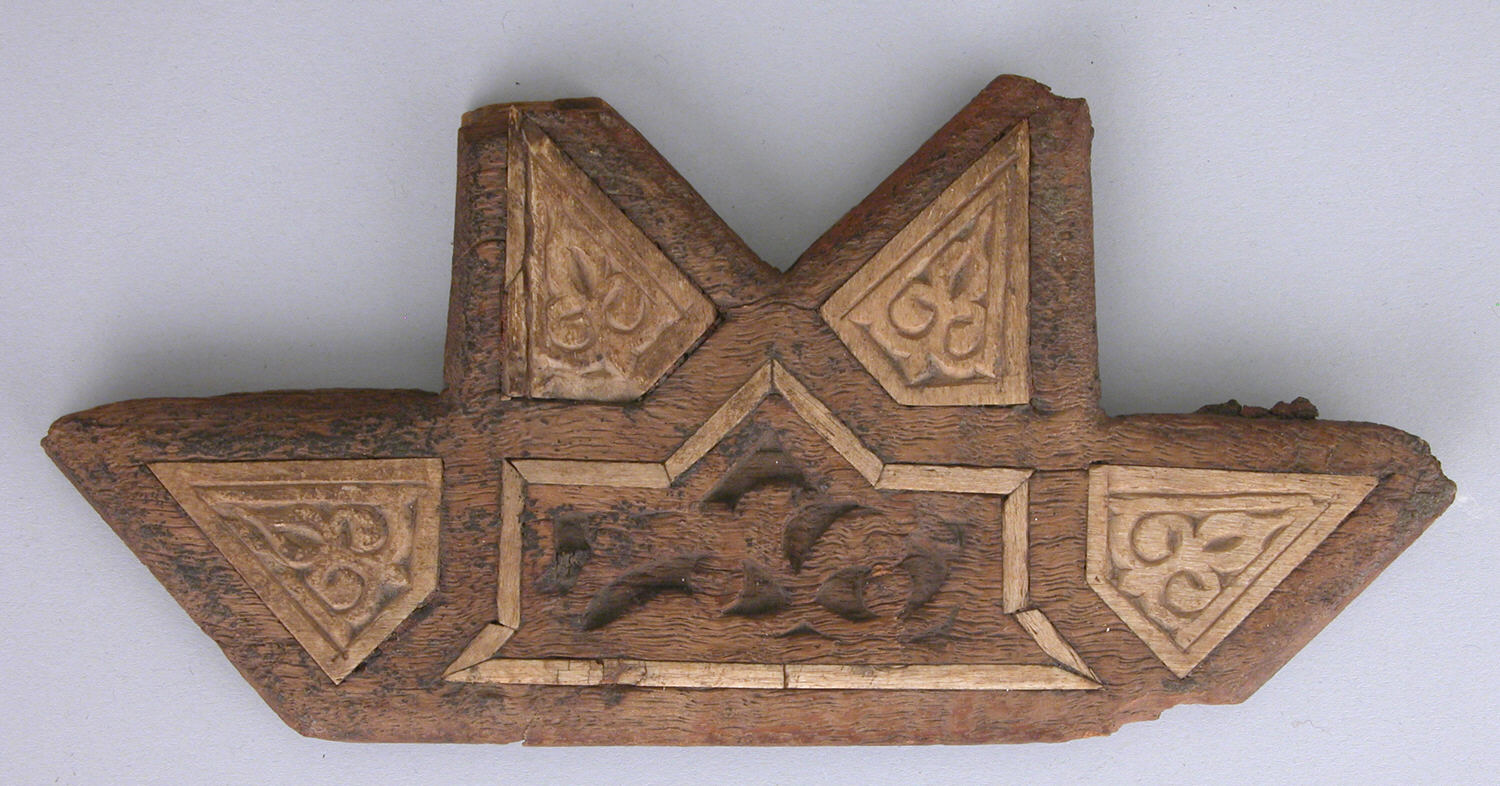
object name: panel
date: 1301-1500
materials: ivory, wood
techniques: carving, inlay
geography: egypt